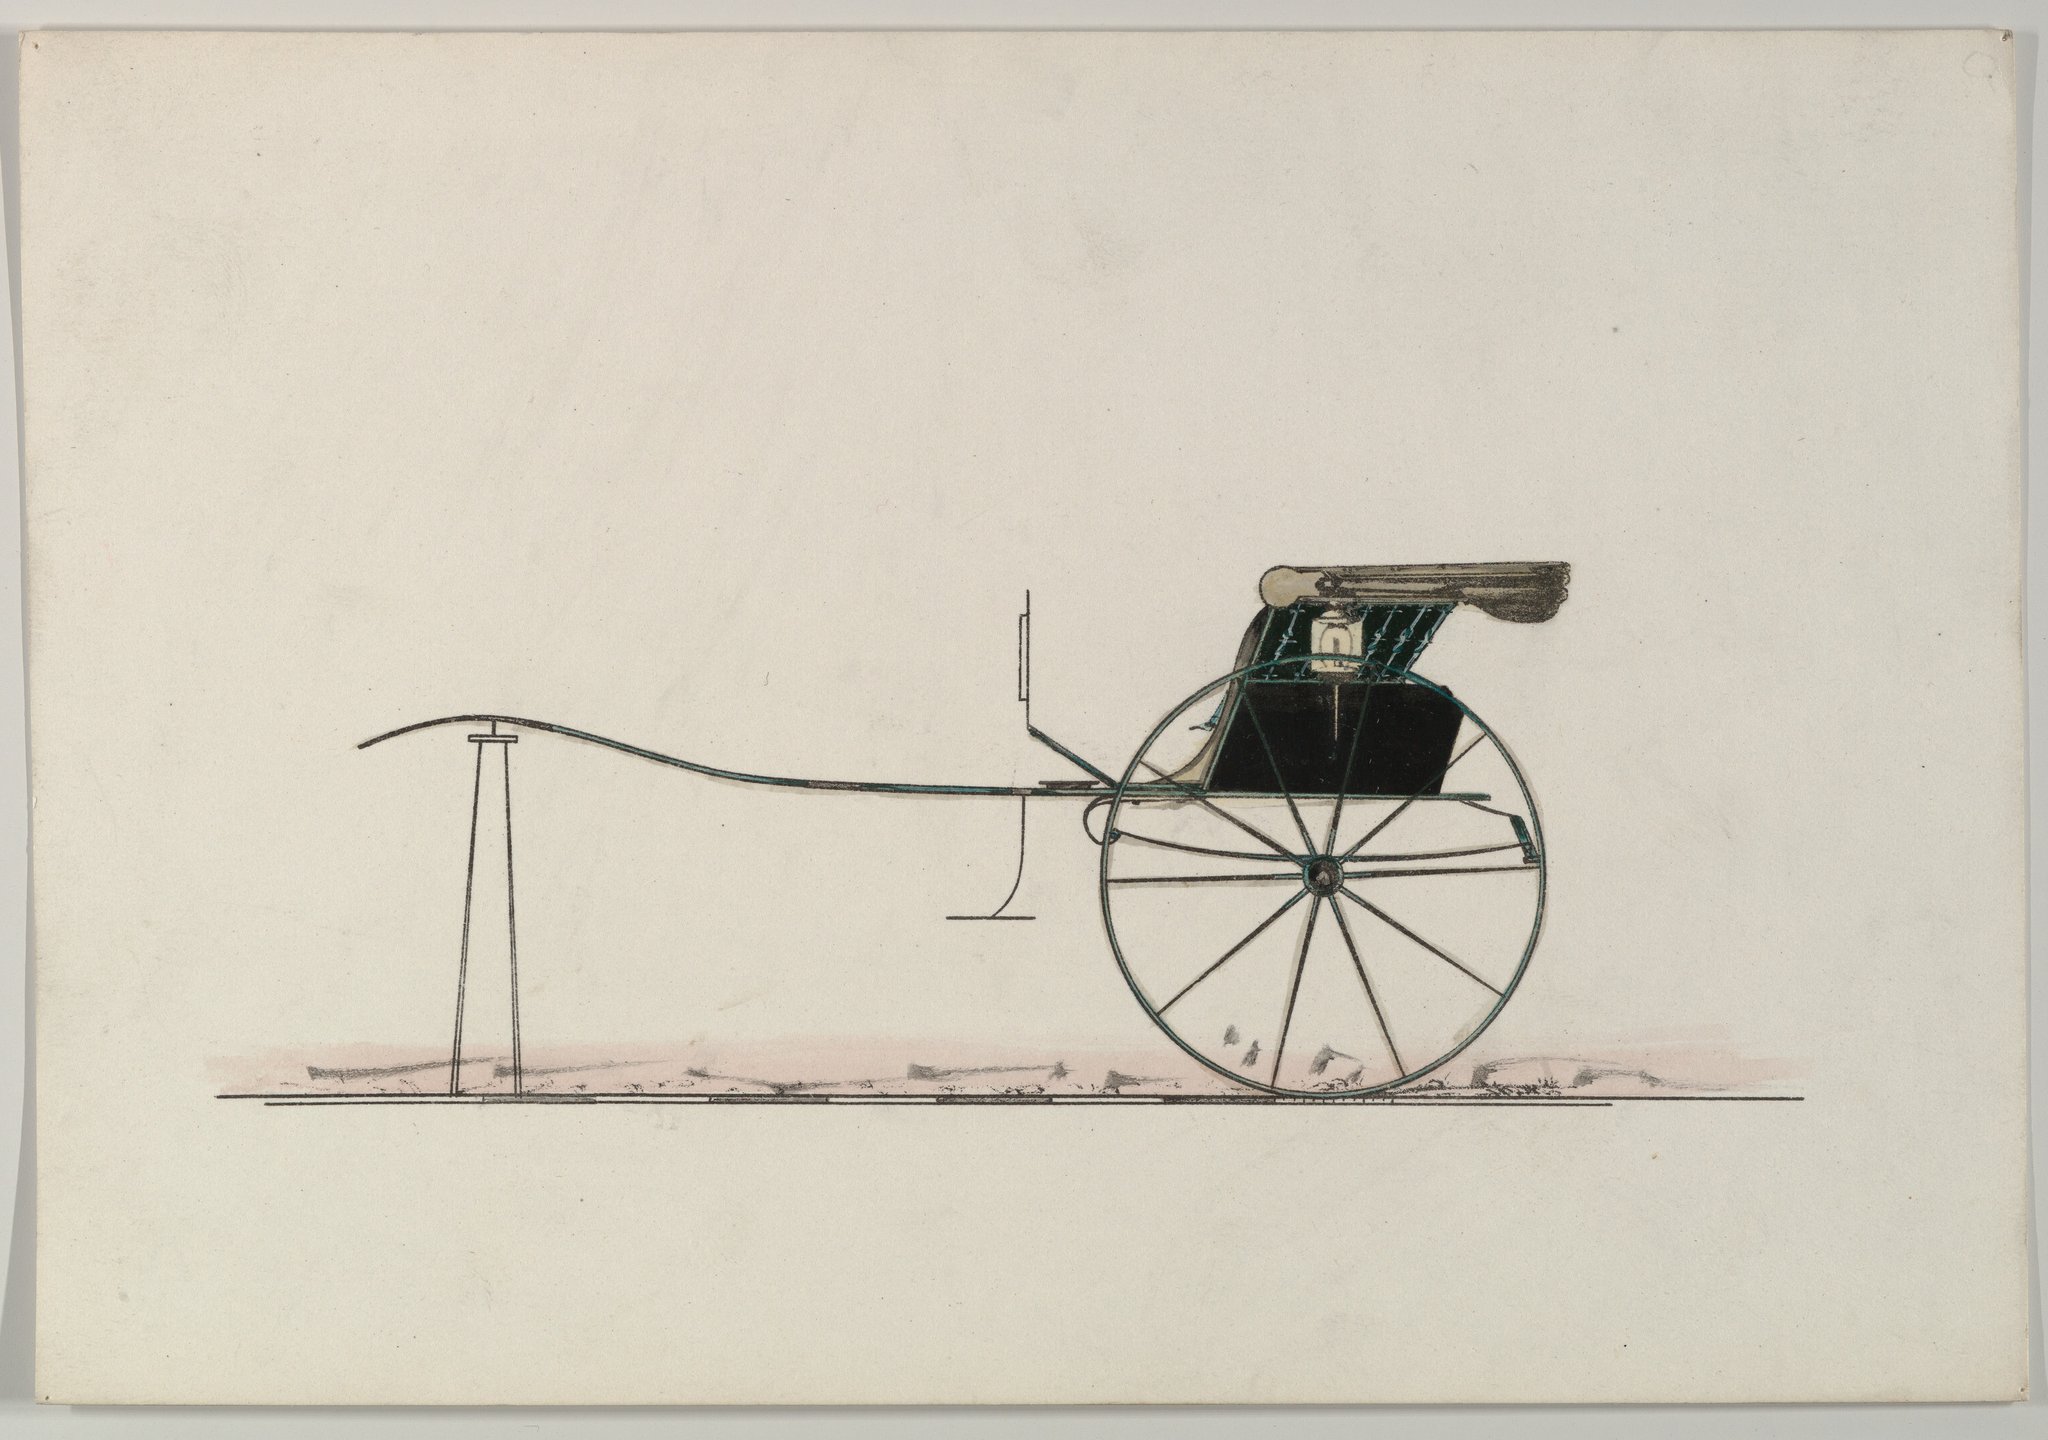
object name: drawing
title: Stanhope Gig (unnumbered)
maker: brewster & co.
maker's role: manufacturer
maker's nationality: american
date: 1850-1874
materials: gouache, gum arabic, ink, watercolor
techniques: pen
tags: carriages